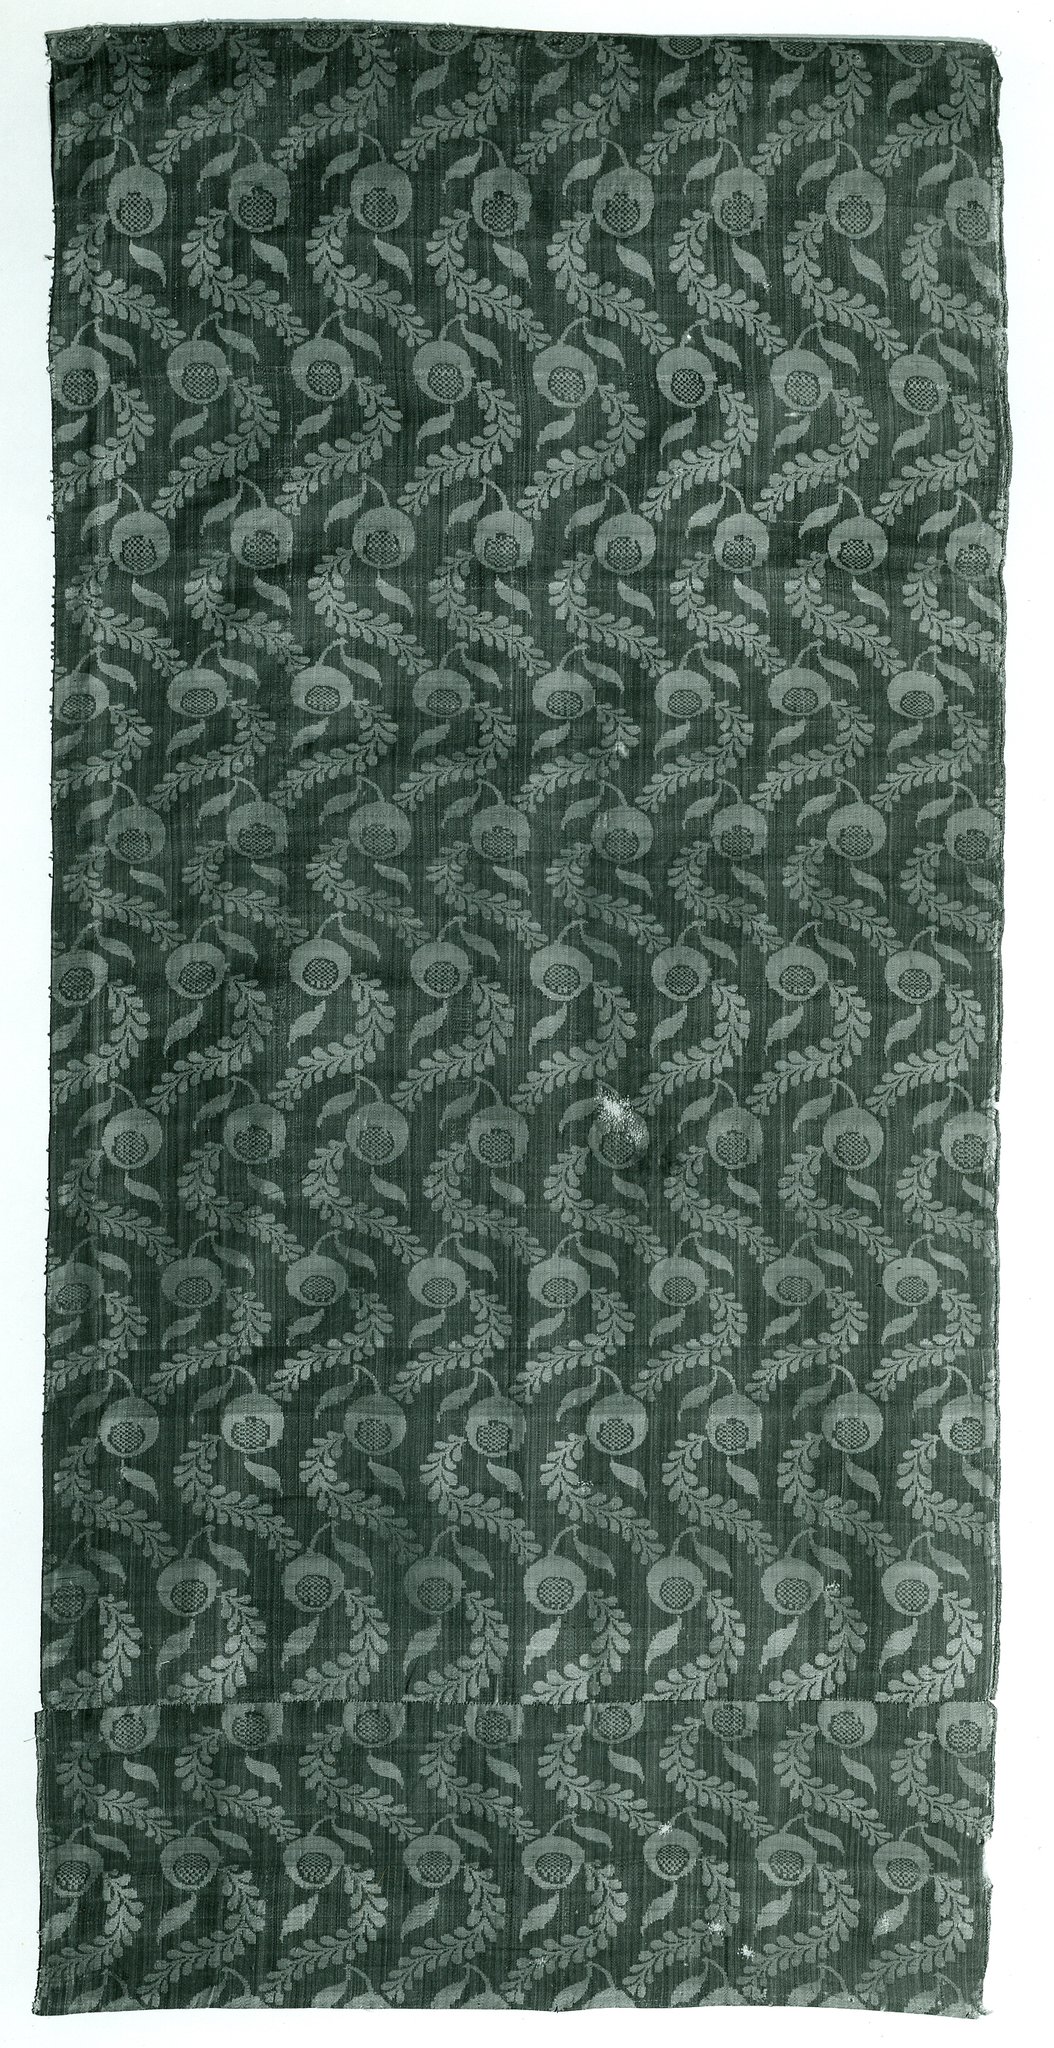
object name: textile panel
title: Panel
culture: french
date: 1701-1800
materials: cotton, silk